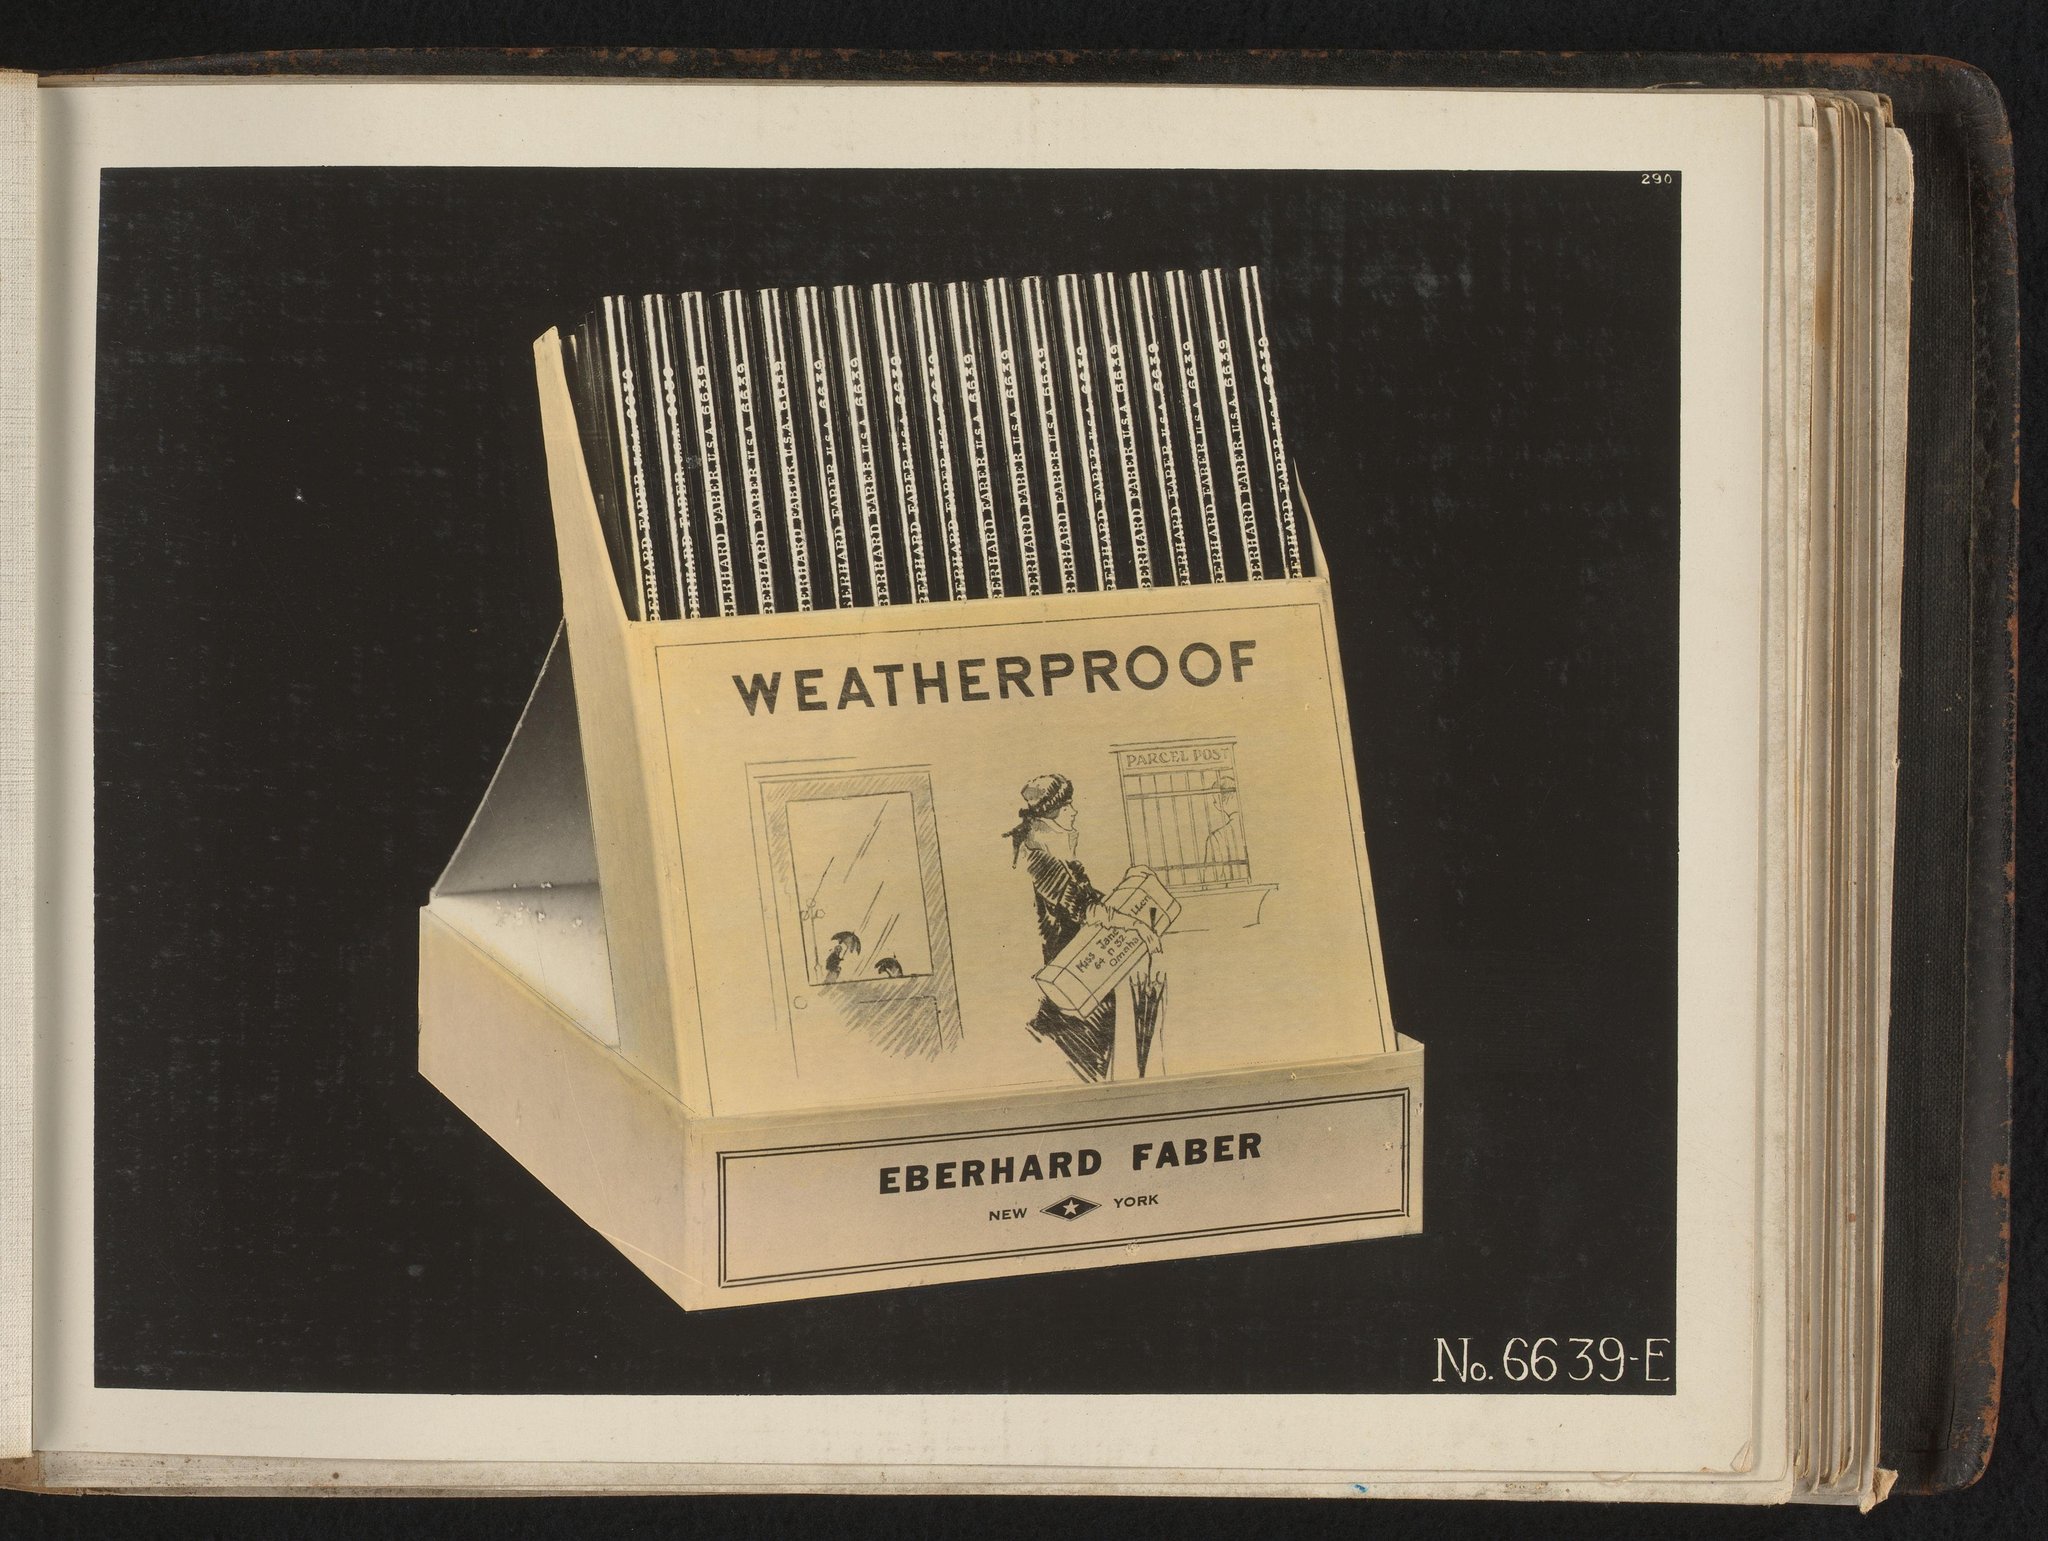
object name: album leaf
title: Standaard met potloden van Eberhard Faber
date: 1915-1935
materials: paper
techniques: gelatin silver print, hand coloring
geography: springfield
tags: pencil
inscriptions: stamp: ‘Paramount/ Commercial Studios/ 145 Chestnut St./ Springfield - Mass.’, number: ‘290’